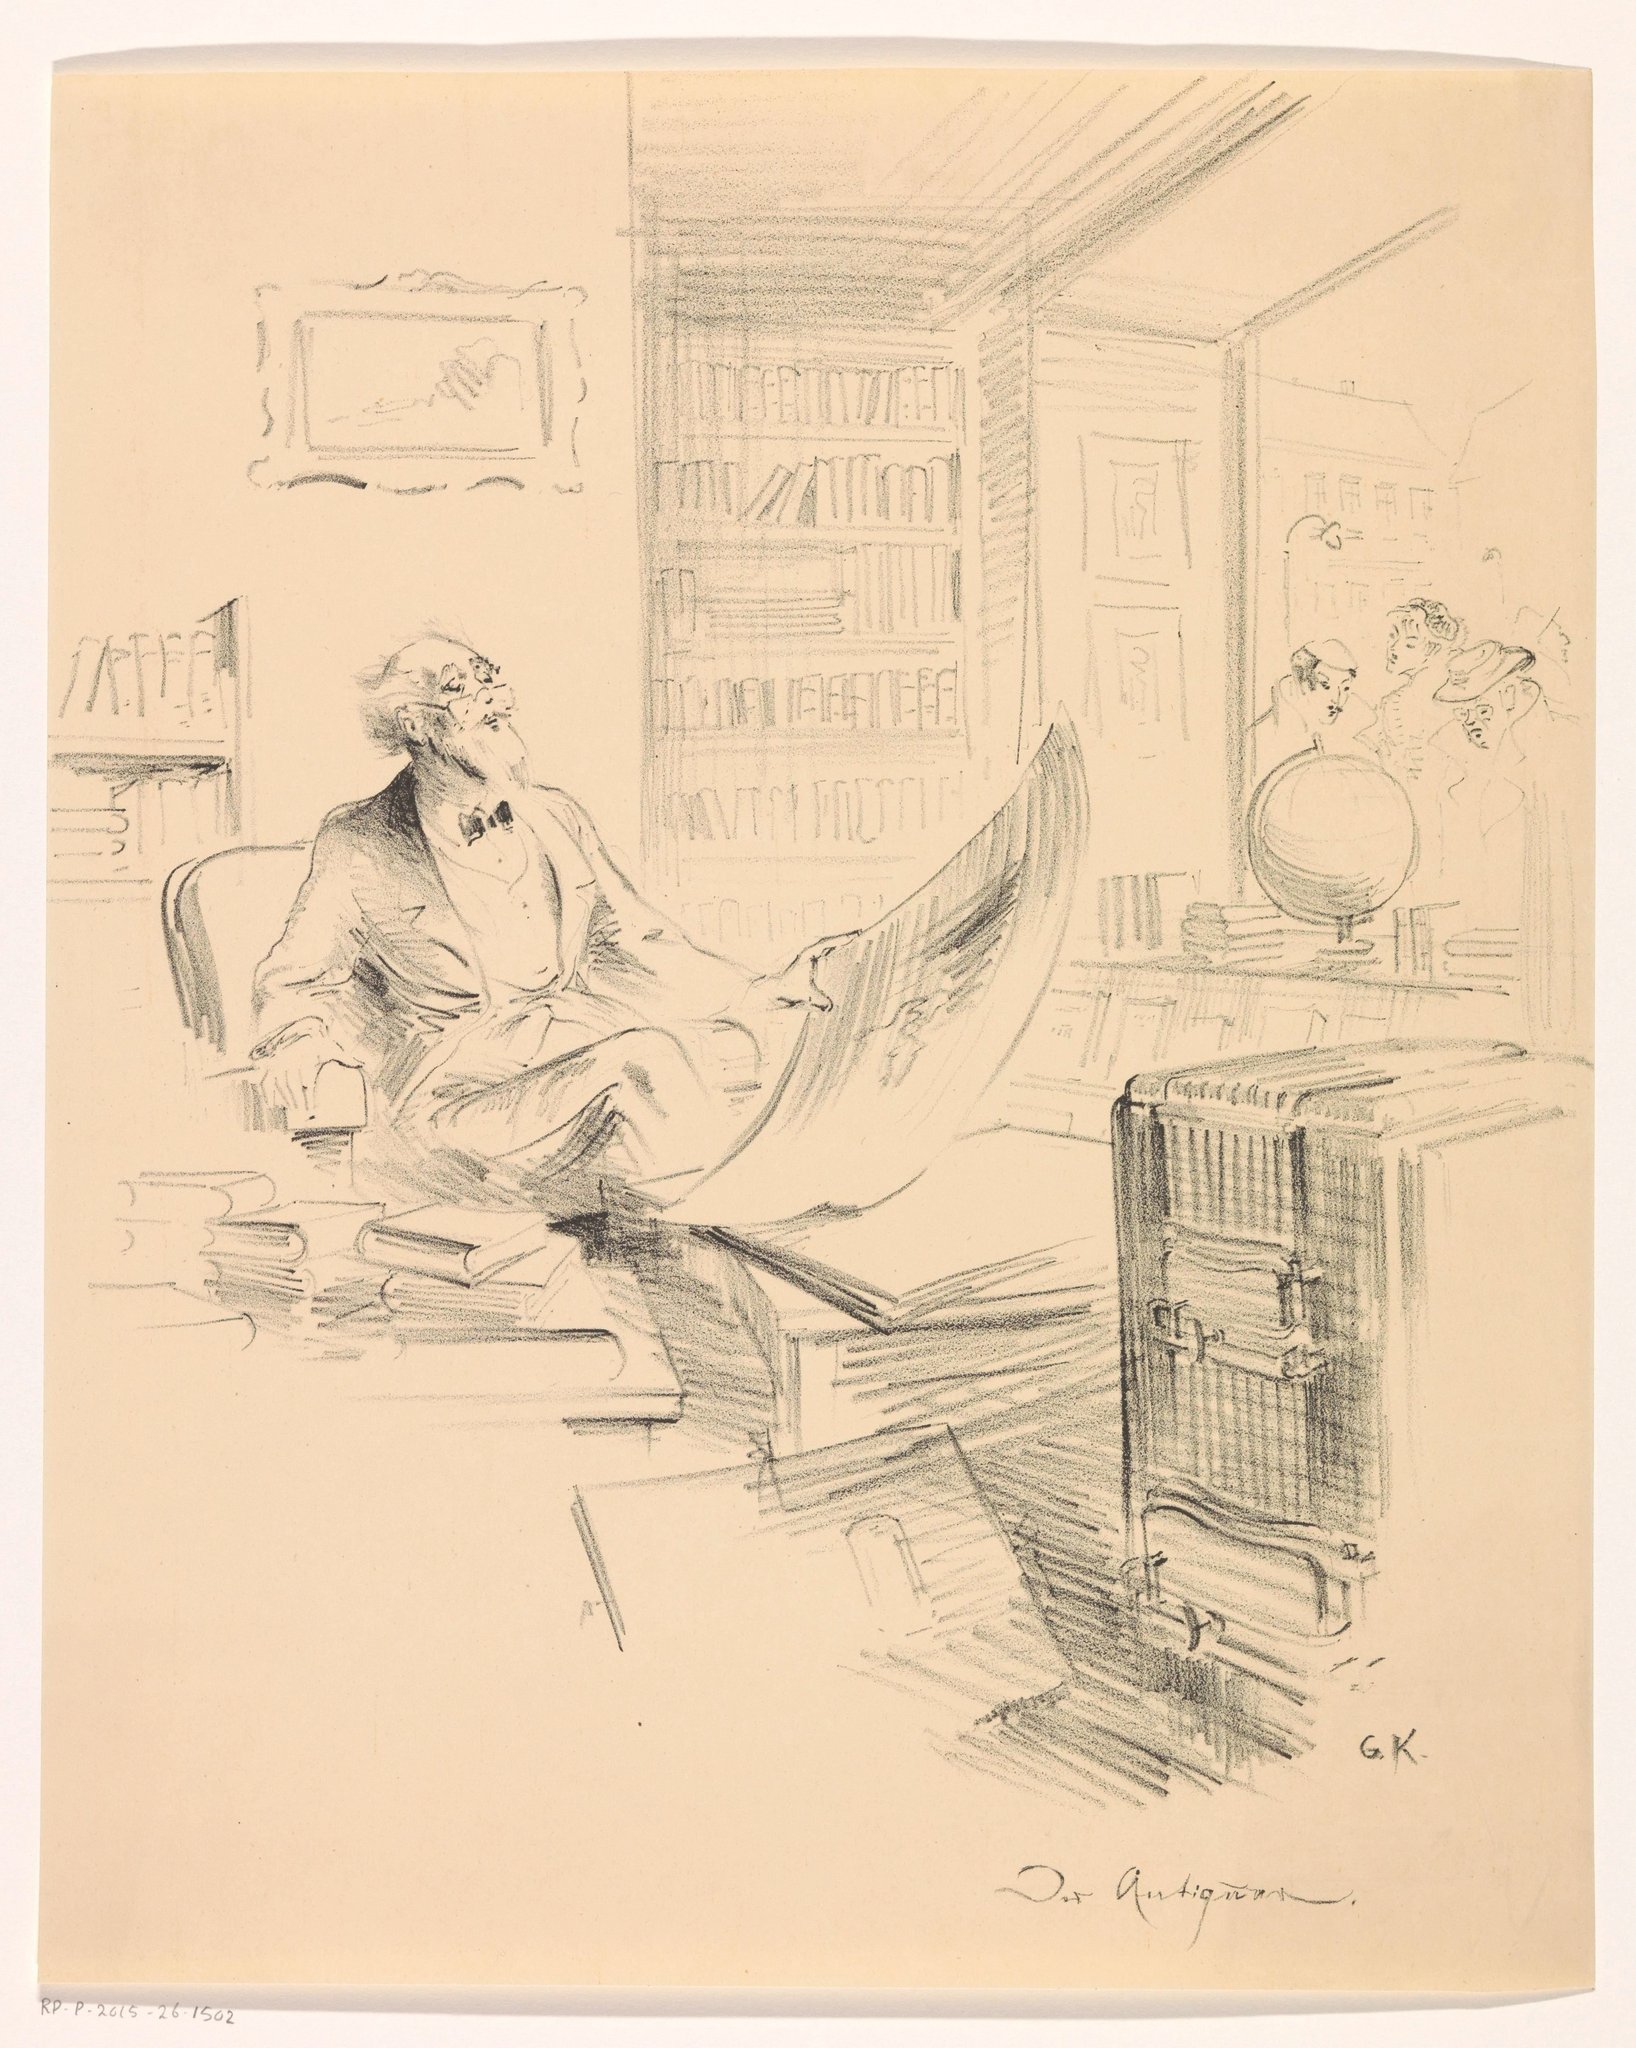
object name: print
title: Der Antiquar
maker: monogrammist gk (prentmaker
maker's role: print maker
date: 1900-1925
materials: paper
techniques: lithograph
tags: heating stove, shop-window, show-window, book-shop, bookseller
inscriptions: collector's mark: Lugt 4780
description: Een boekhandelaar zit op een stoel in zijn antiquariaat met een prent in zijn handen. Door de etalage kijken mensen naar binnen. Op de voorgrond staat een kachel.